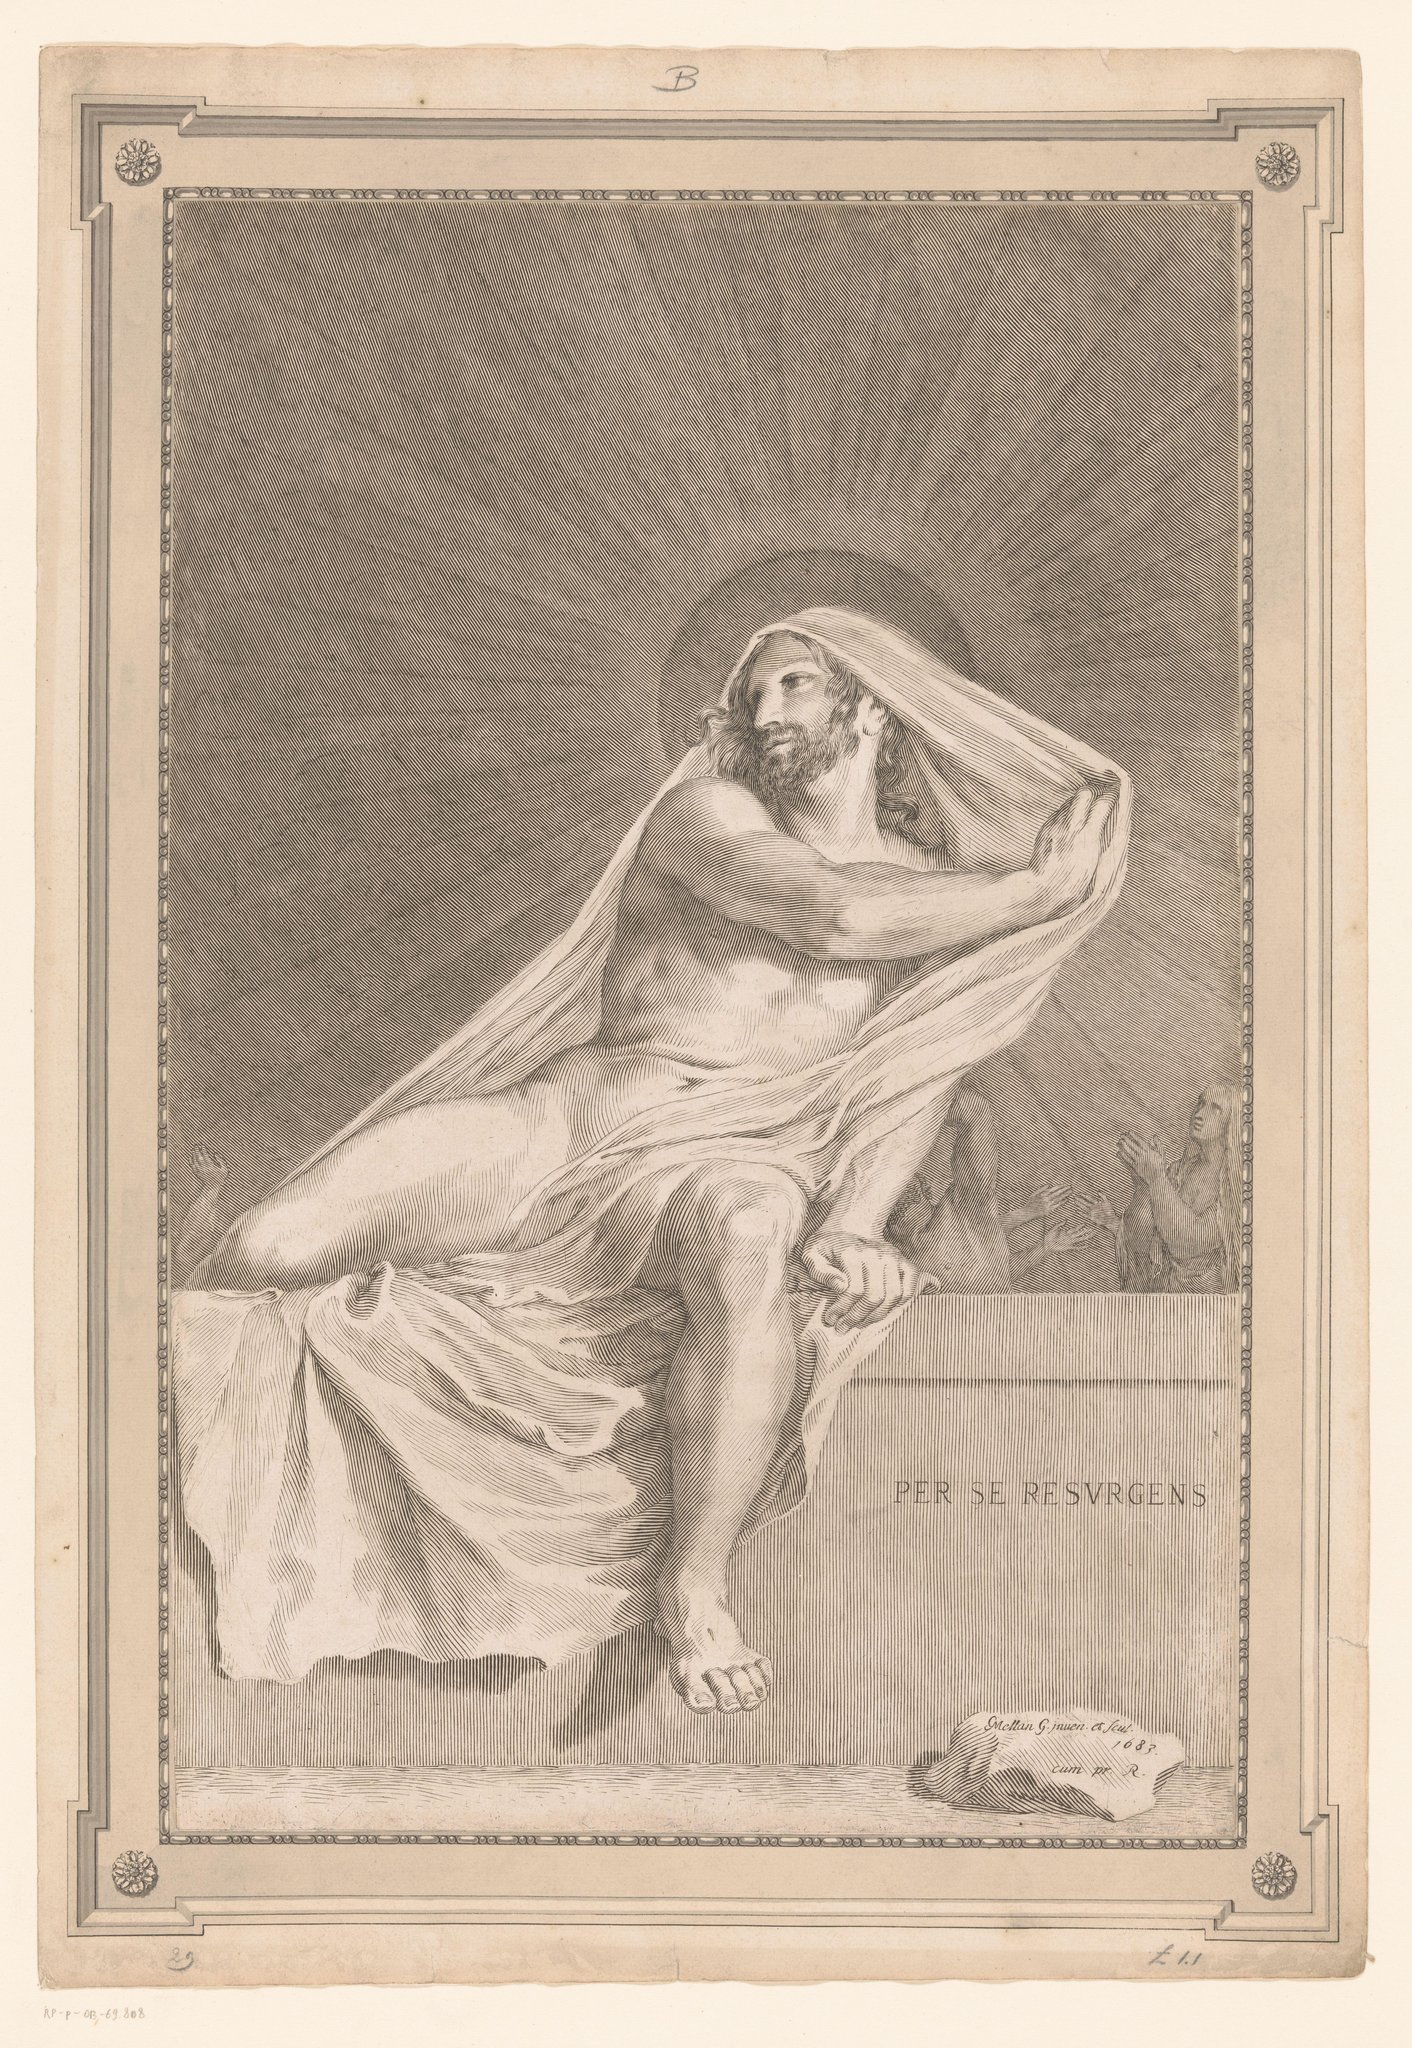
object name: print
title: Verrijzenis van Christus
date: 1683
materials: paper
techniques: engraving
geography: france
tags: christ, usually holding a banner, arises from the grave; often combined with sleeping and/or frightened soldiers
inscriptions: watermark, collector's mark: Lugt 2228